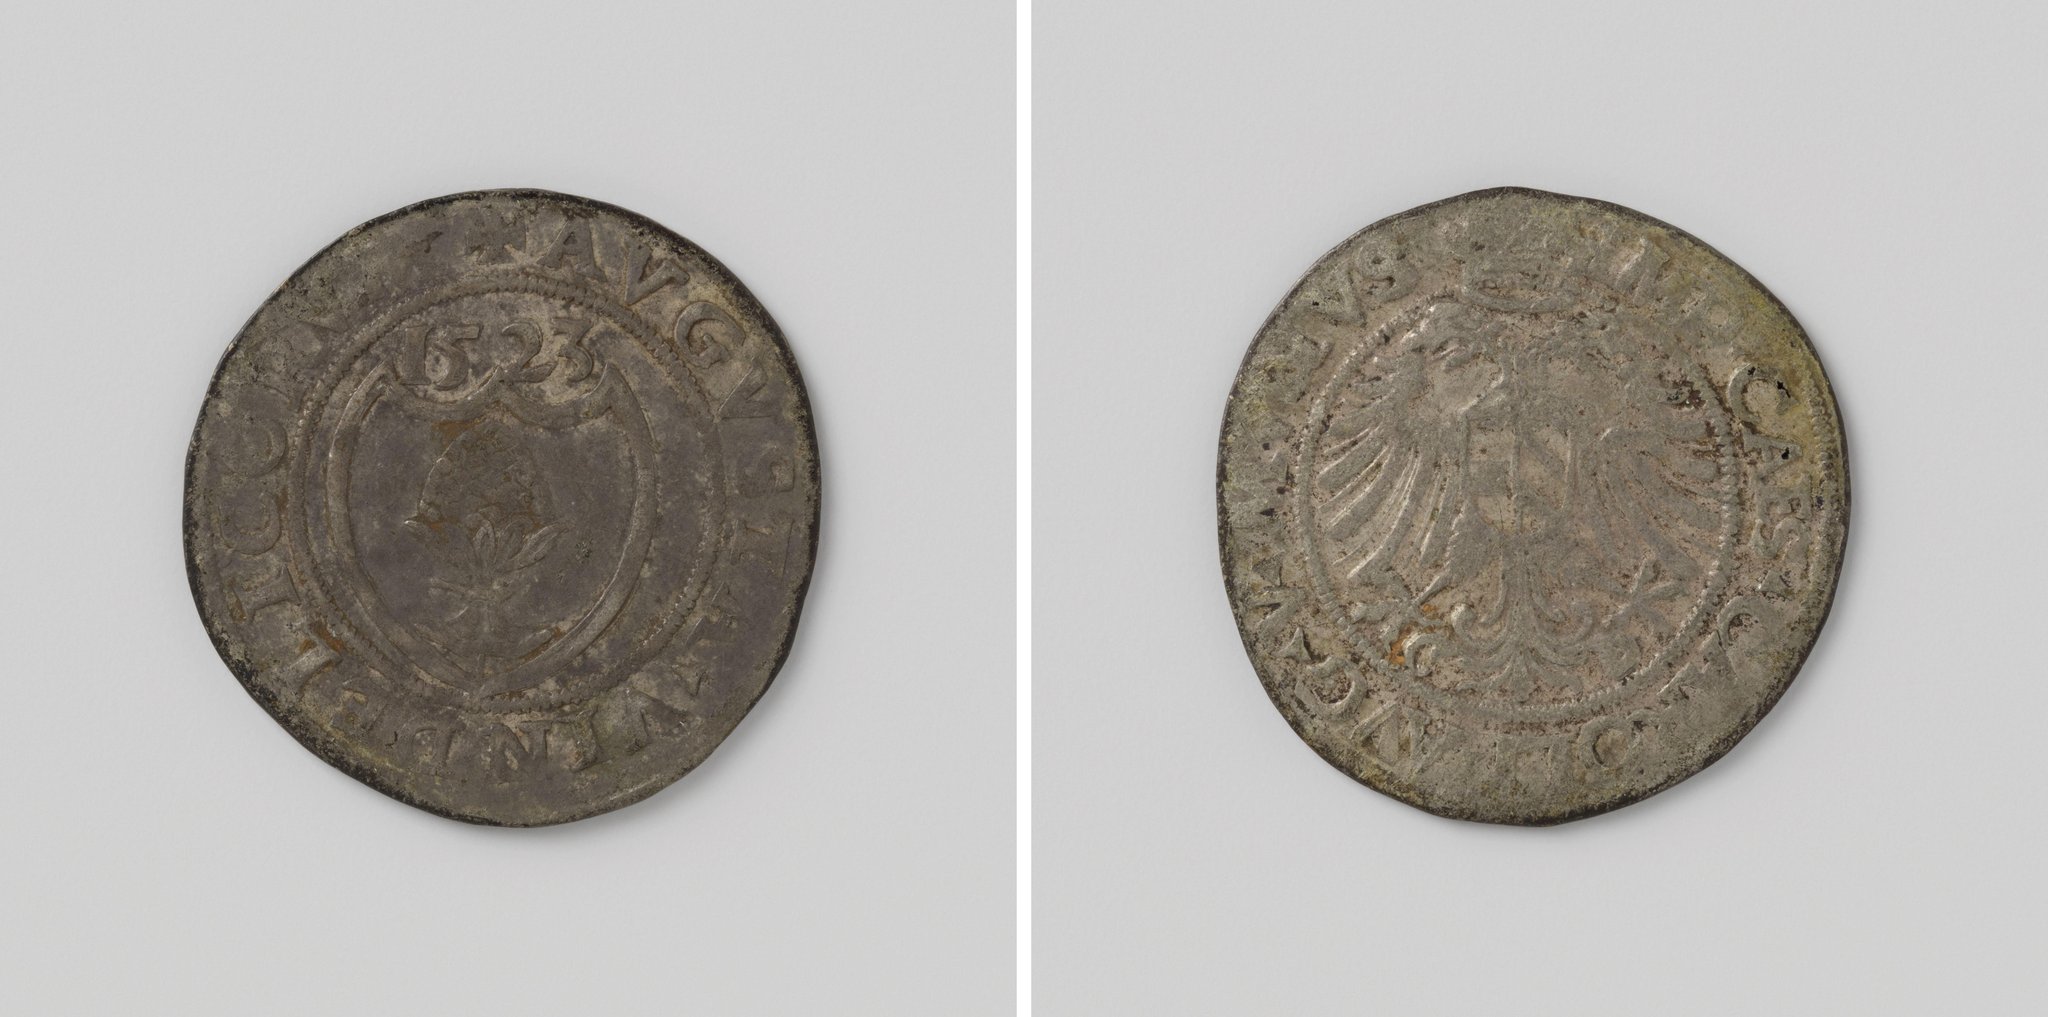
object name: history medal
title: Karel V, Duits keizer verleent het muntrecht aan Augsburg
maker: Anonymous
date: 1523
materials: silver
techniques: striking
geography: augsburg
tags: ghent, charles v (holy roman emperor and king of spain), augsburg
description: Zilveren penning. Voorzijde: wapenschild onder jaartal binnen omschrift. Keerzijde: gekroonde, dubbelkoppige adelaar met schild voor borst binnen omschrift